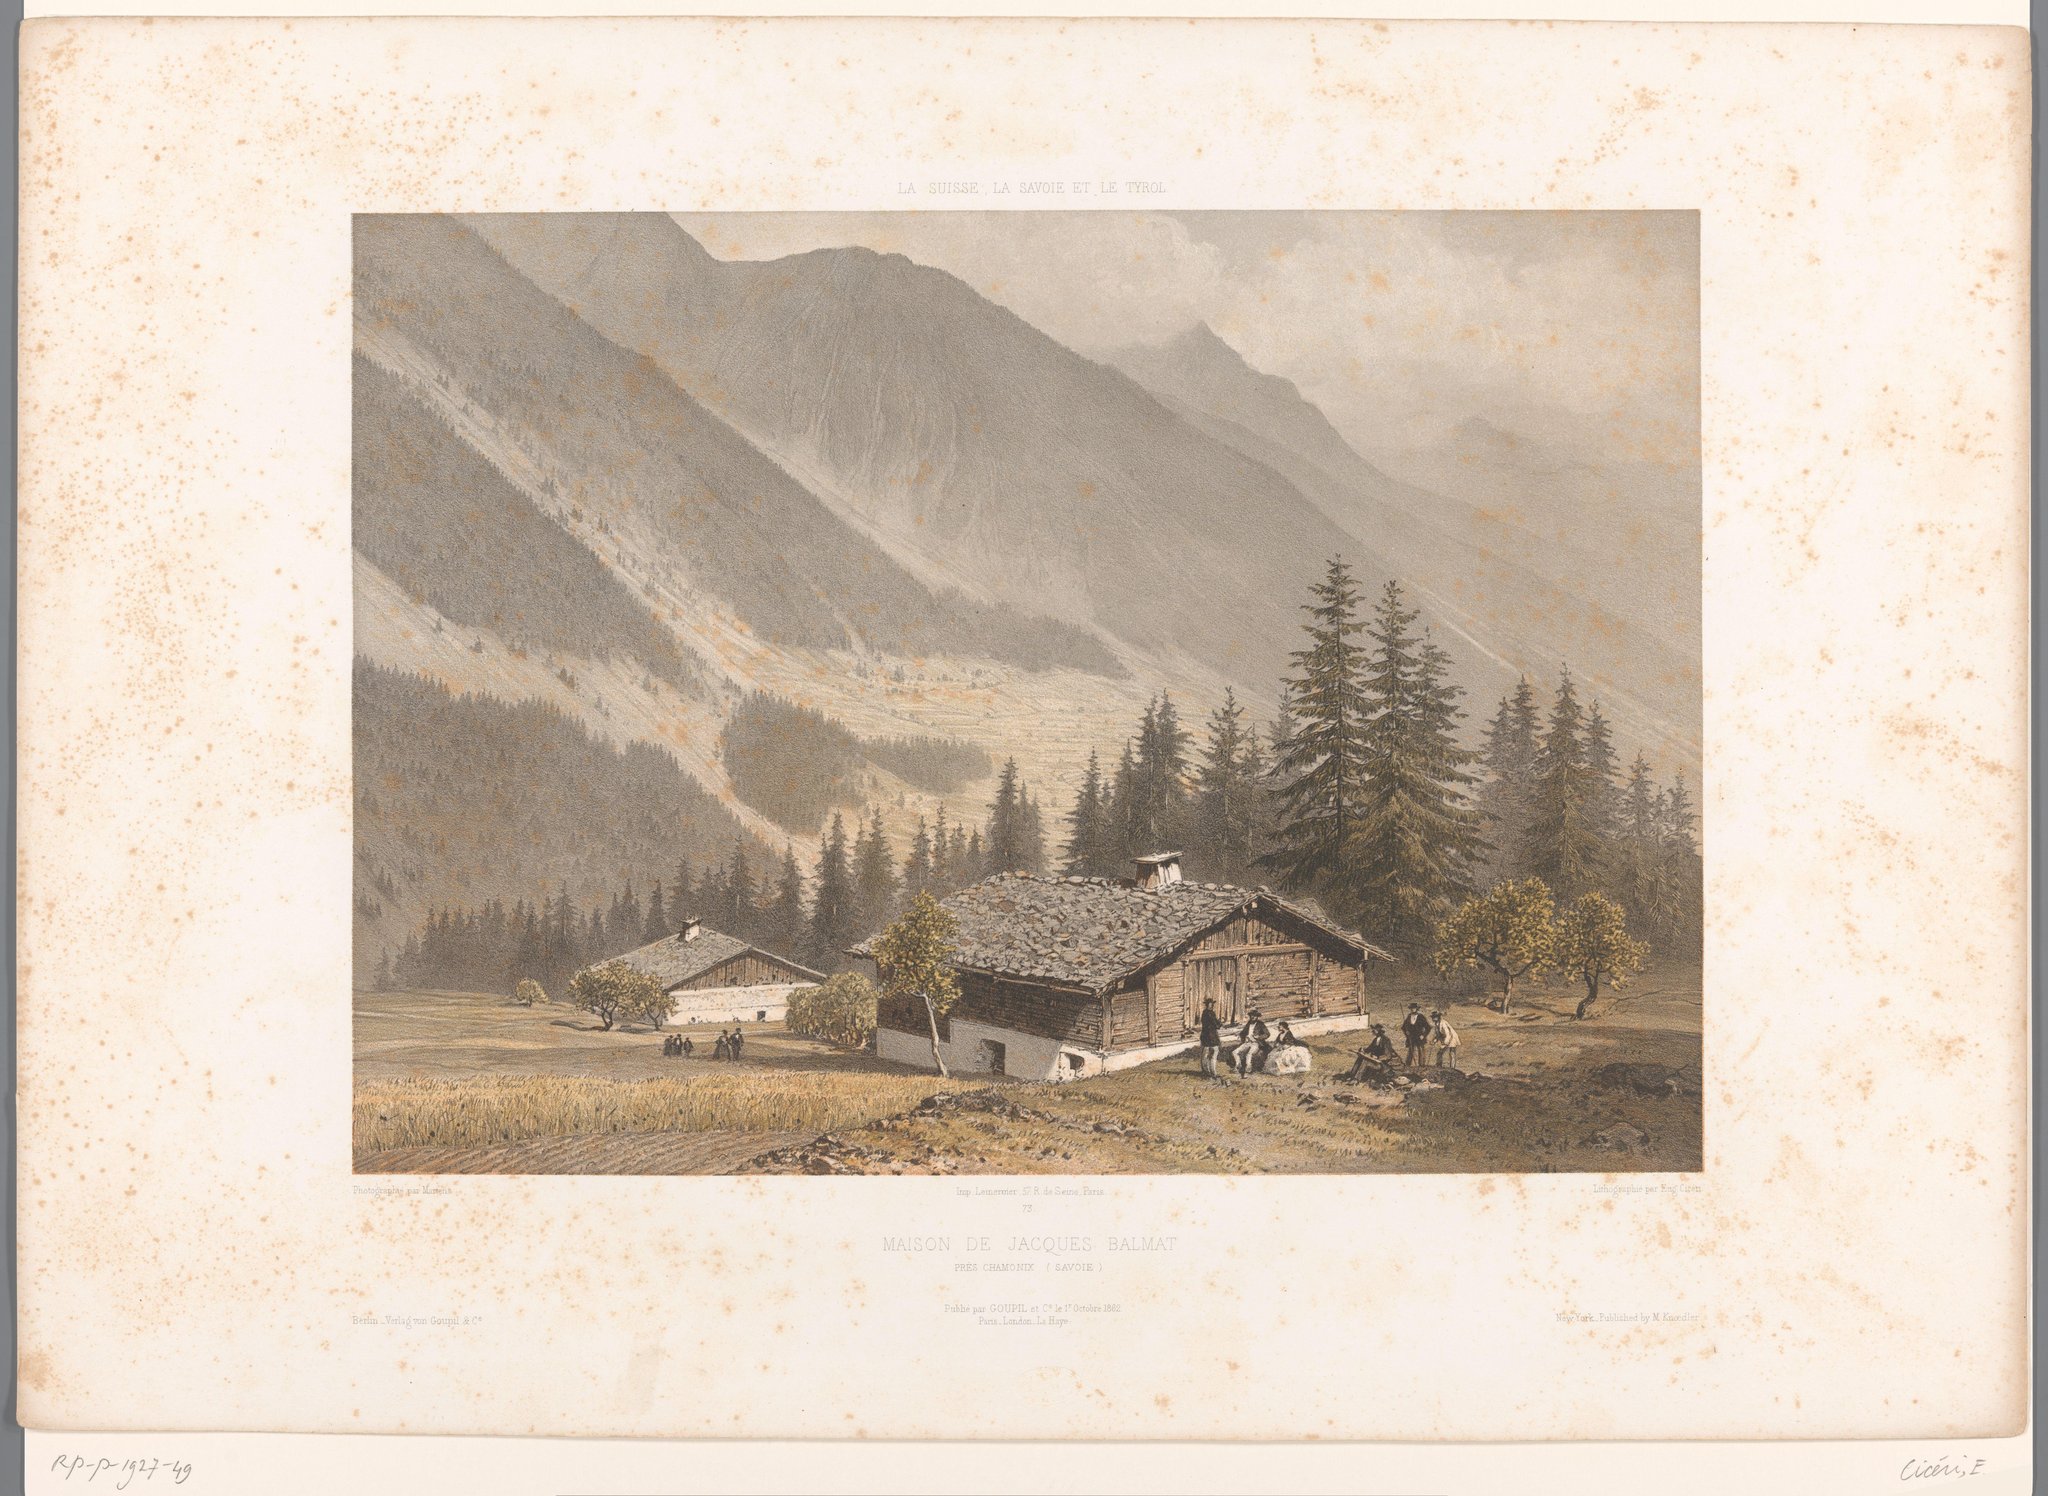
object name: print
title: Zicht op het huis van Jacques Balmat bij Chamonix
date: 1859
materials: paper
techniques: lithograph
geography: paris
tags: mountains (+ landscape with figures, staffage), farm or solitary house in landscape (+ city(-scape) with figures, staffage)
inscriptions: check stamp: Lugt 1090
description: Jacques Balmat kreeg bekendheid als de eerste beklimmer van de Mont Blanc.